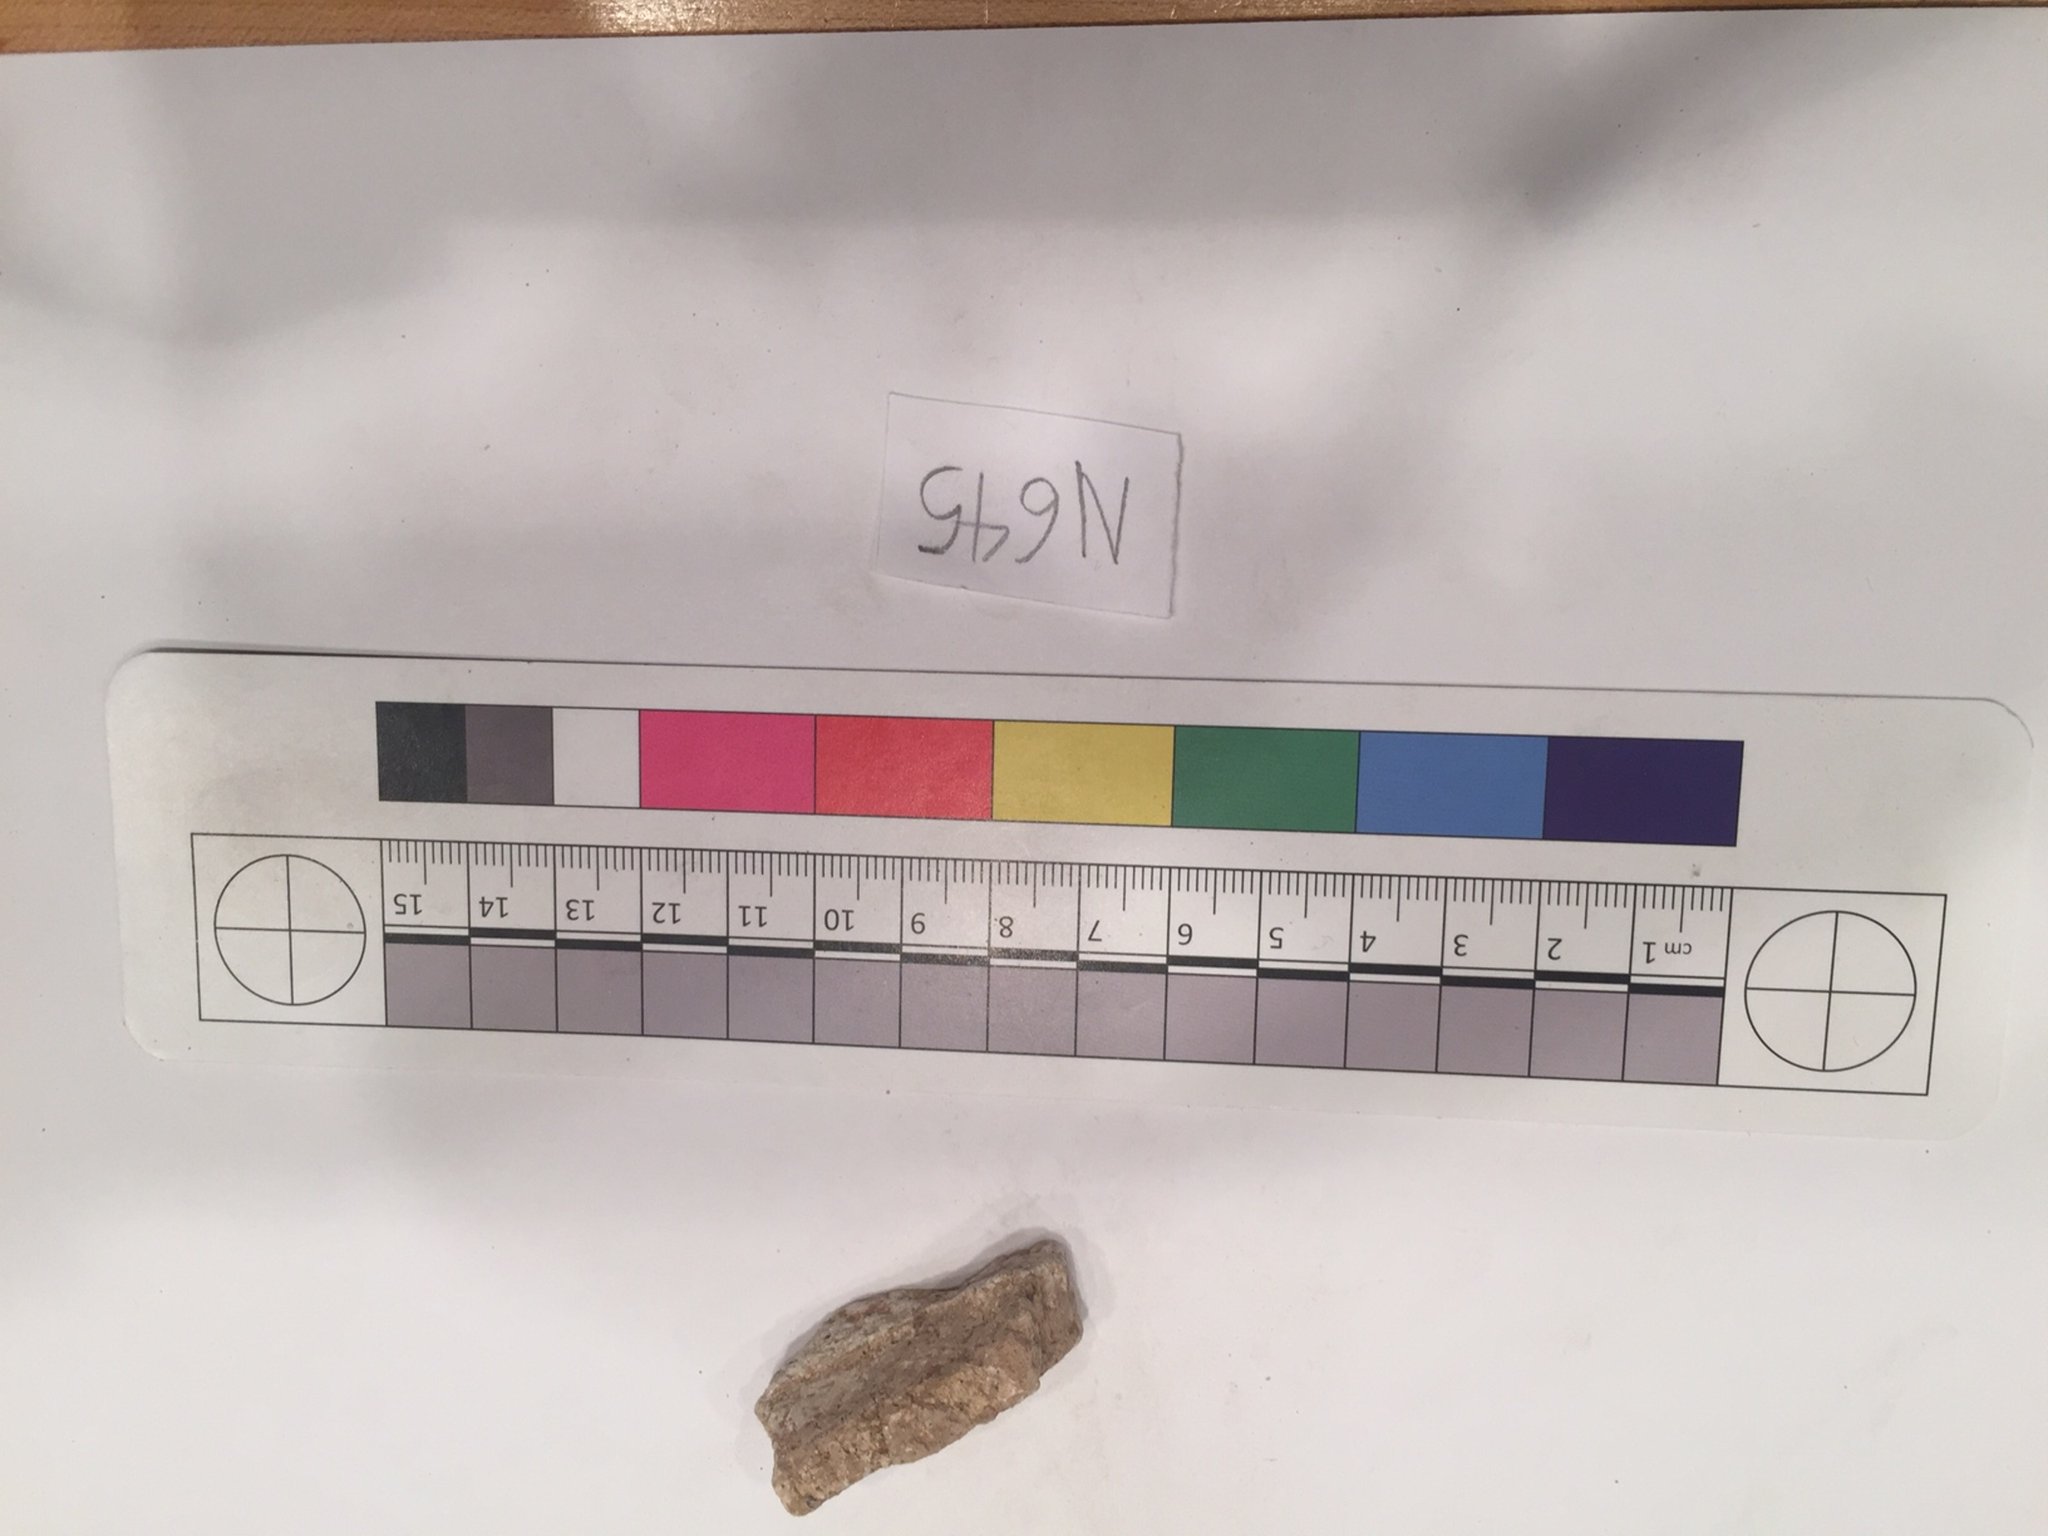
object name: fragment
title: Stucco Fragment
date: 701-1200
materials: plaster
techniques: carving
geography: iran